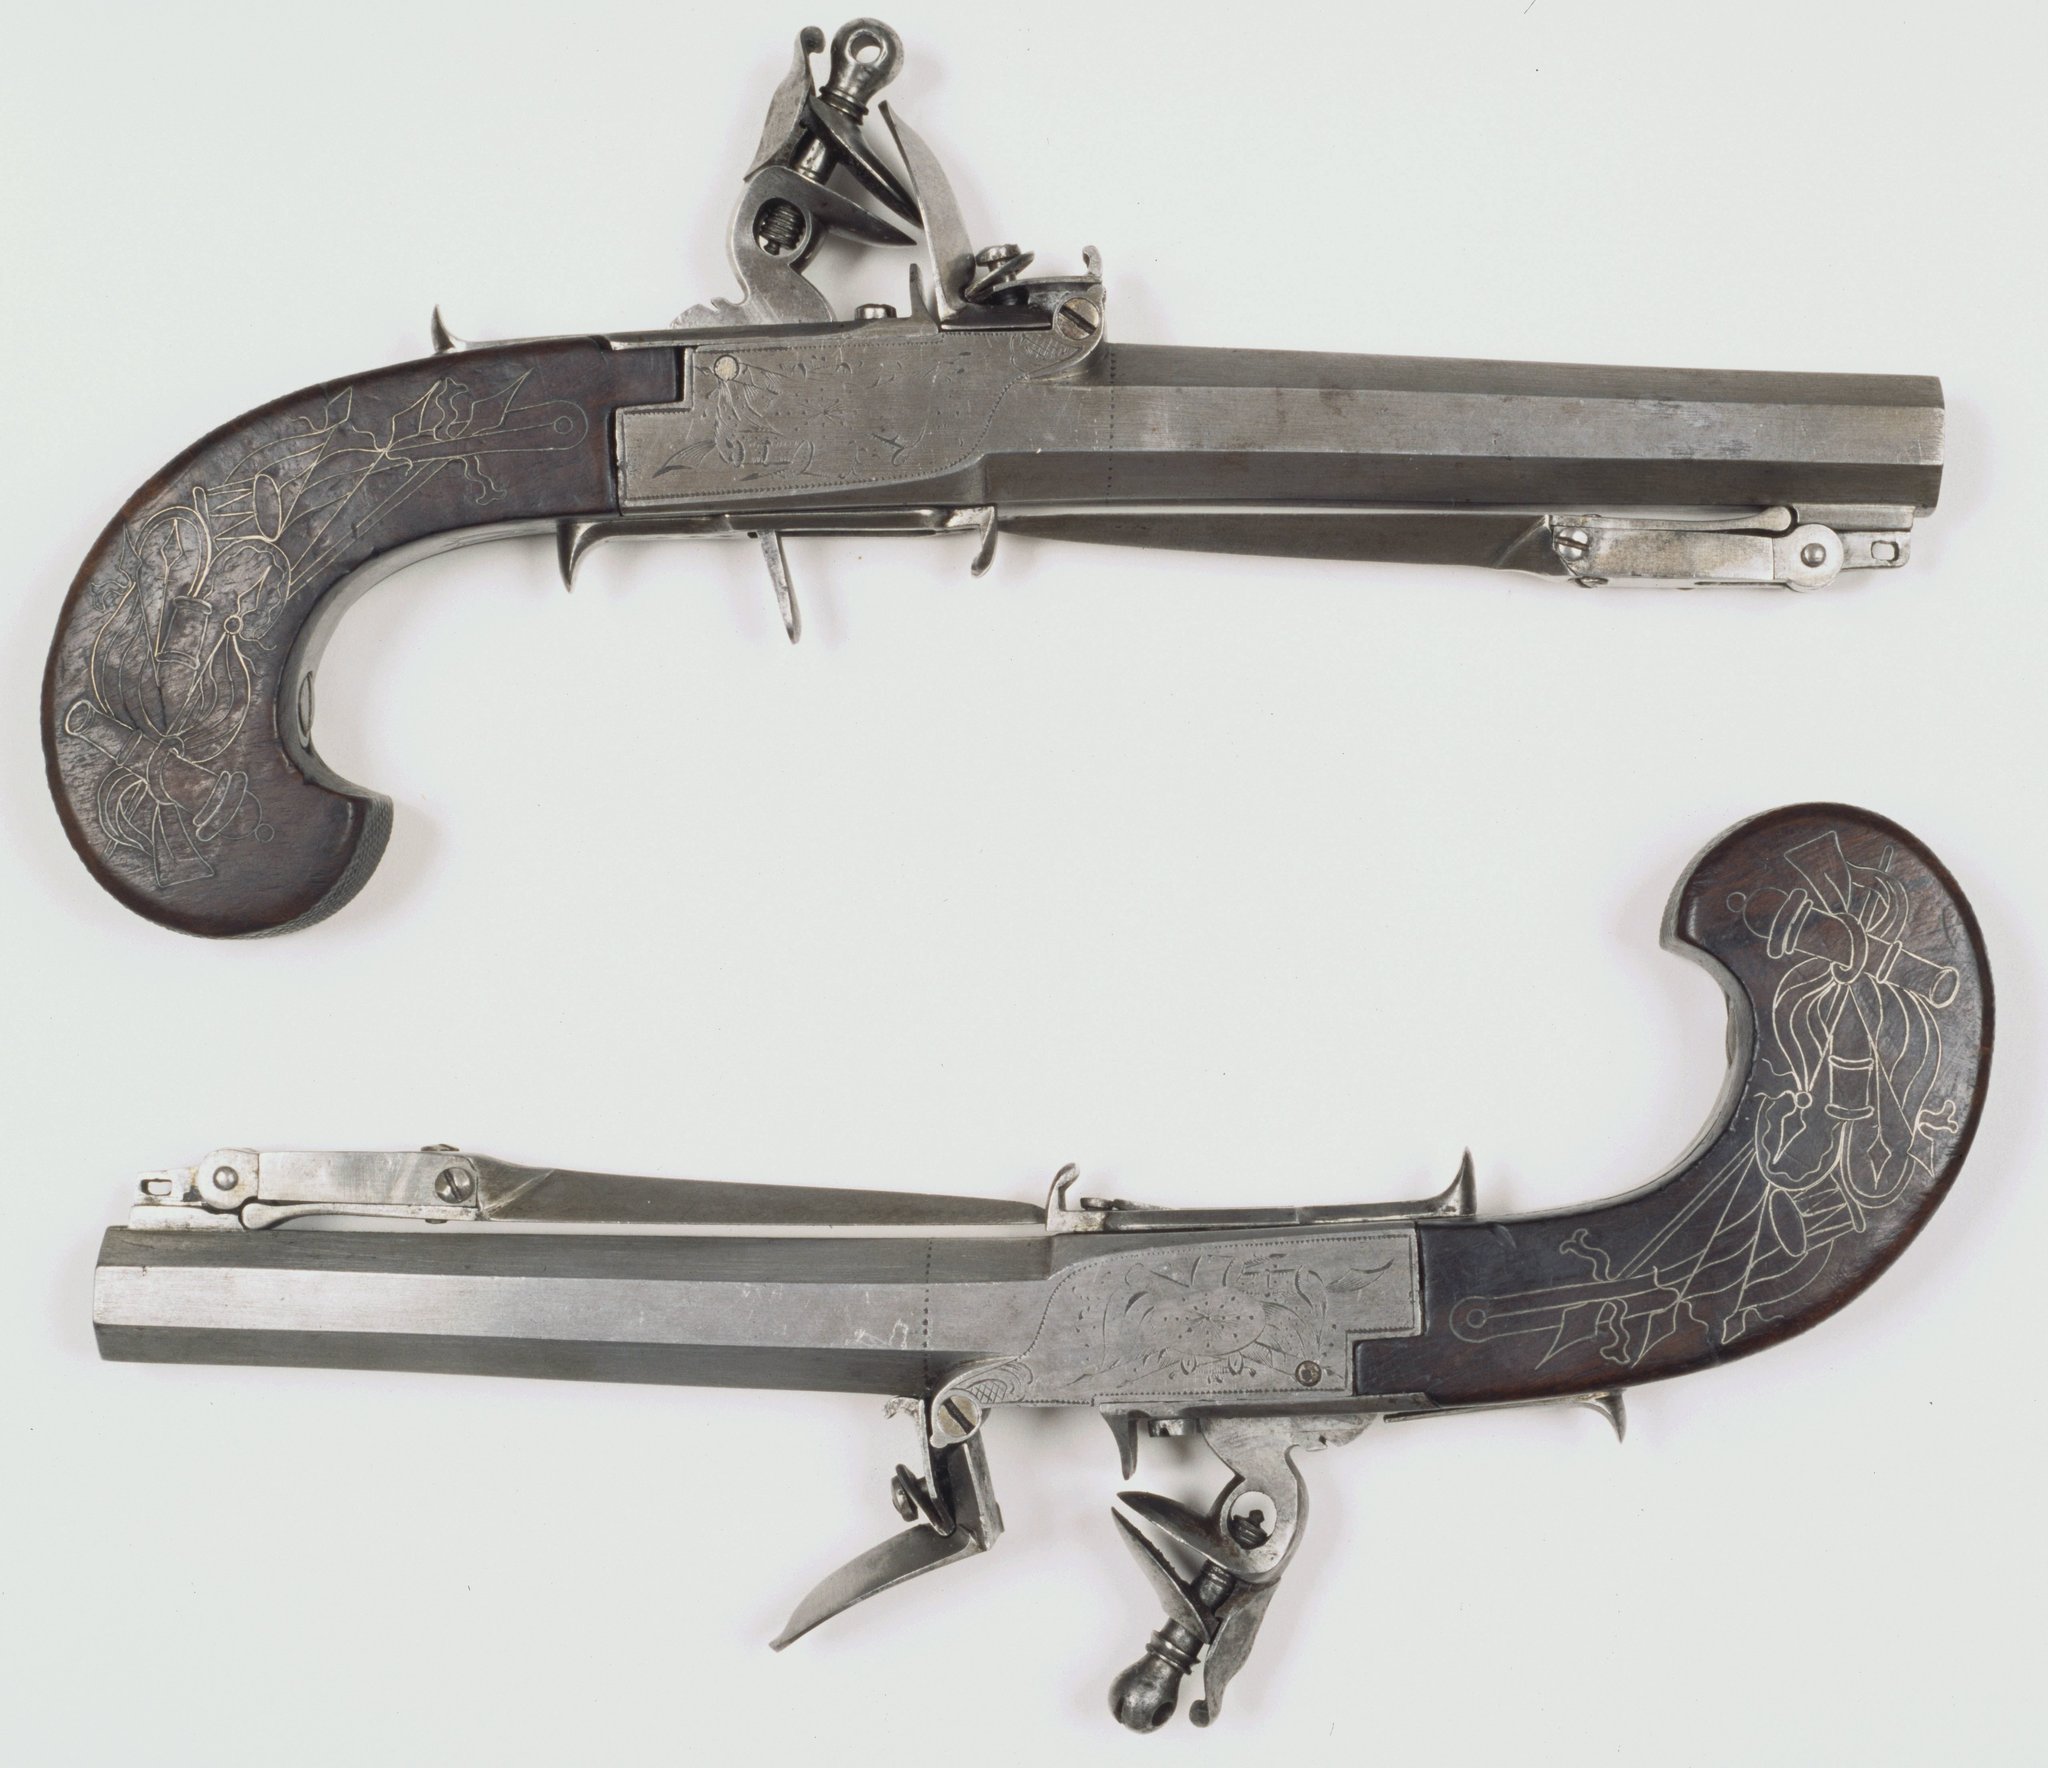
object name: flintlock pistol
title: Vuursteenpistool met bajonet, deel van een koppel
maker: Anonymous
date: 1400-1950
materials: iron, thread, wood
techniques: inlay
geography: western europe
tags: netherlands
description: Vuursteenpistool, deel van koppel, met ijzeren gladde achthoekige loop. Platte slotplaat met gegraveerde wapentrofee, recht opstaande vuurstaal en ijzeren haan. De kolf is van hout en heeft aan de zijkanten een met zilverdraad ingelegde figuren van een kanon, trommels en vaandels. De kolfhals is geribbeld. Onder de loop een inklapbare bajonet die aan een scharnier aan het uiteinde van de loop bevestigd is. Geen trekkerbeugel, een rechte inklapbare ijzeren trekker onder de slotplaat.